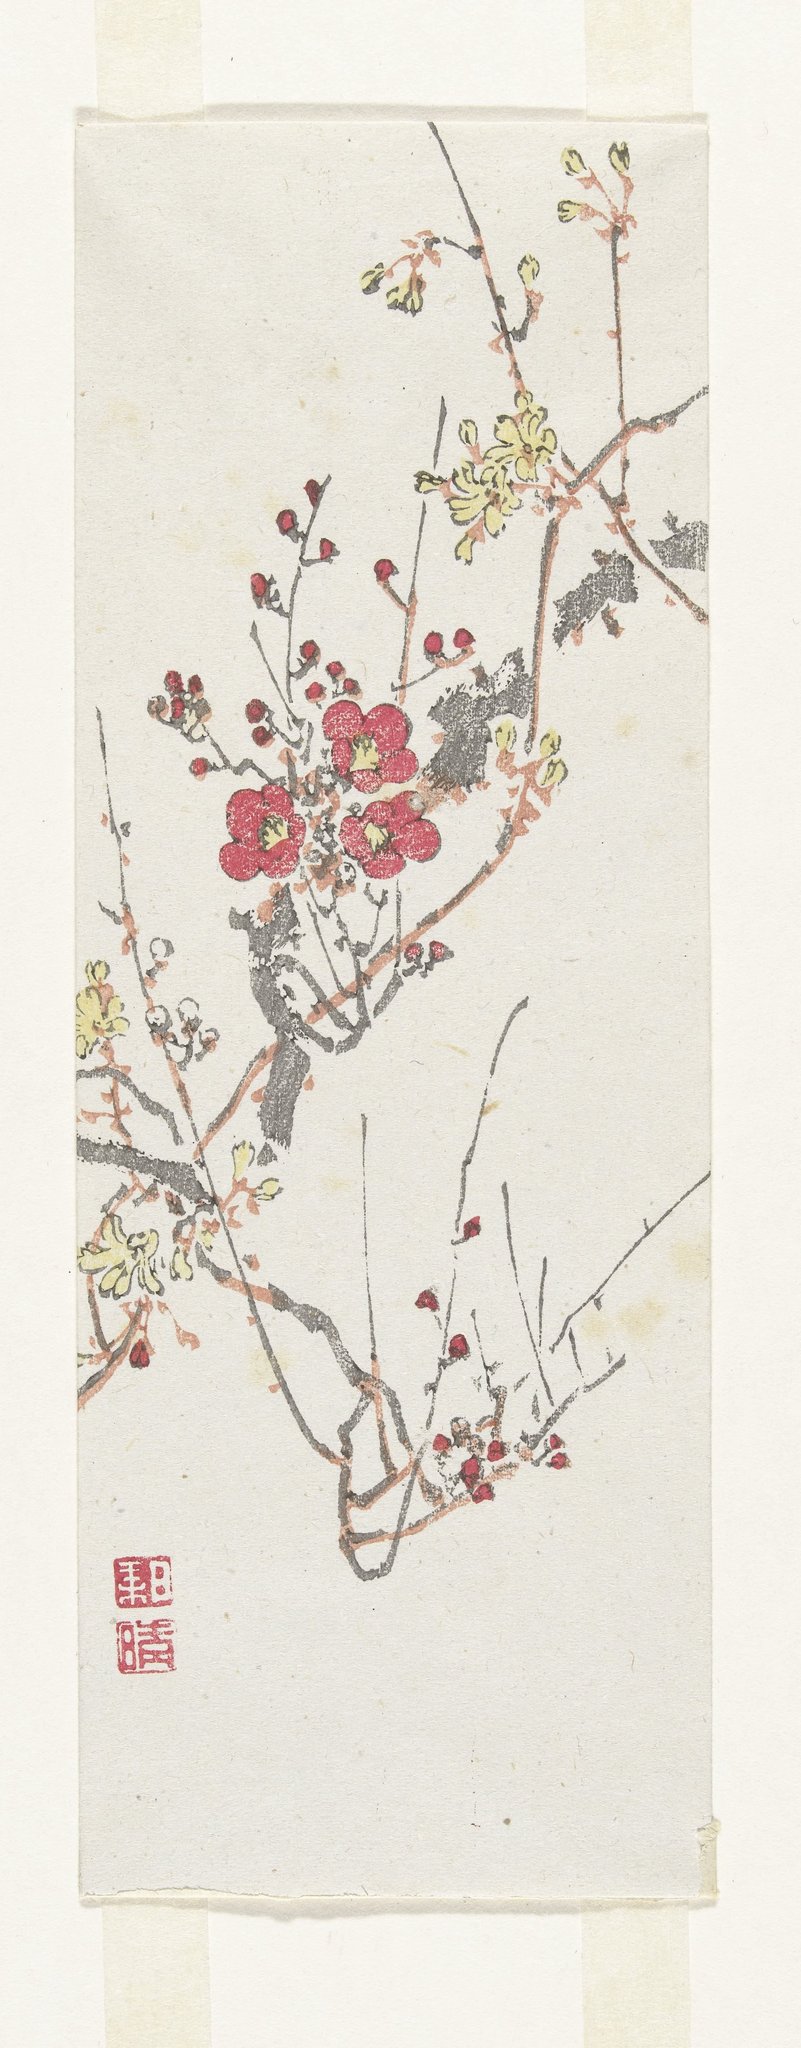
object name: print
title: Rode en gele bloesem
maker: Anonymous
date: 1900-1970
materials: paper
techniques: woodcut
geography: japan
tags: flowers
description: Envelopje voor gedichtenpapier, gedecoreerd met bloeiende rode bloesems.